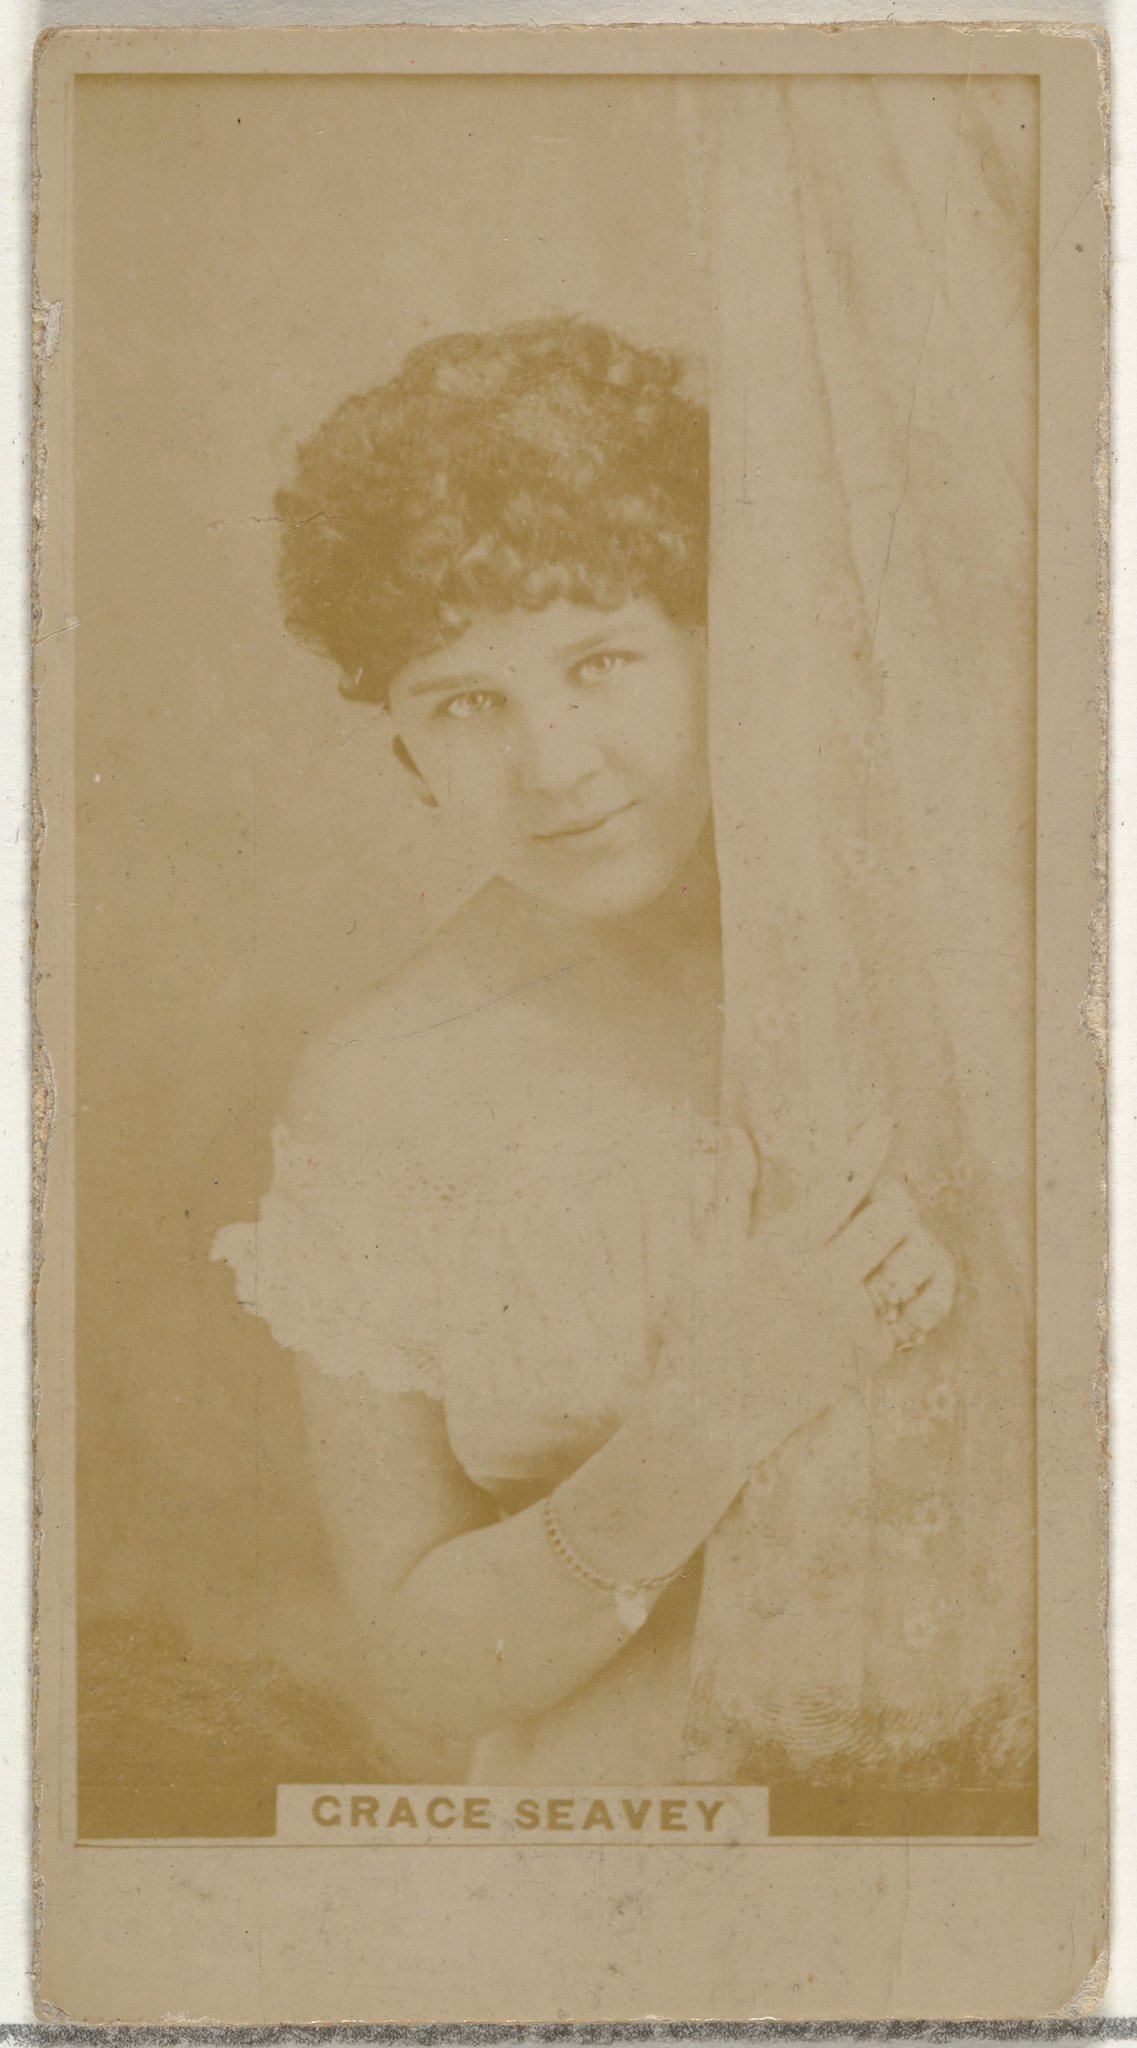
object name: photograph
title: Grace Seavey, from the Actors and Actresses series (N145-8) issued by Duke Sons & Co. to promote Duke Cigarettes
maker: w. duke, sons & co.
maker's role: publisher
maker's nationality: american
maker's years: 1870-1920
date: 1891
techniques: albumen silver print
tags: portraits,women,actresses